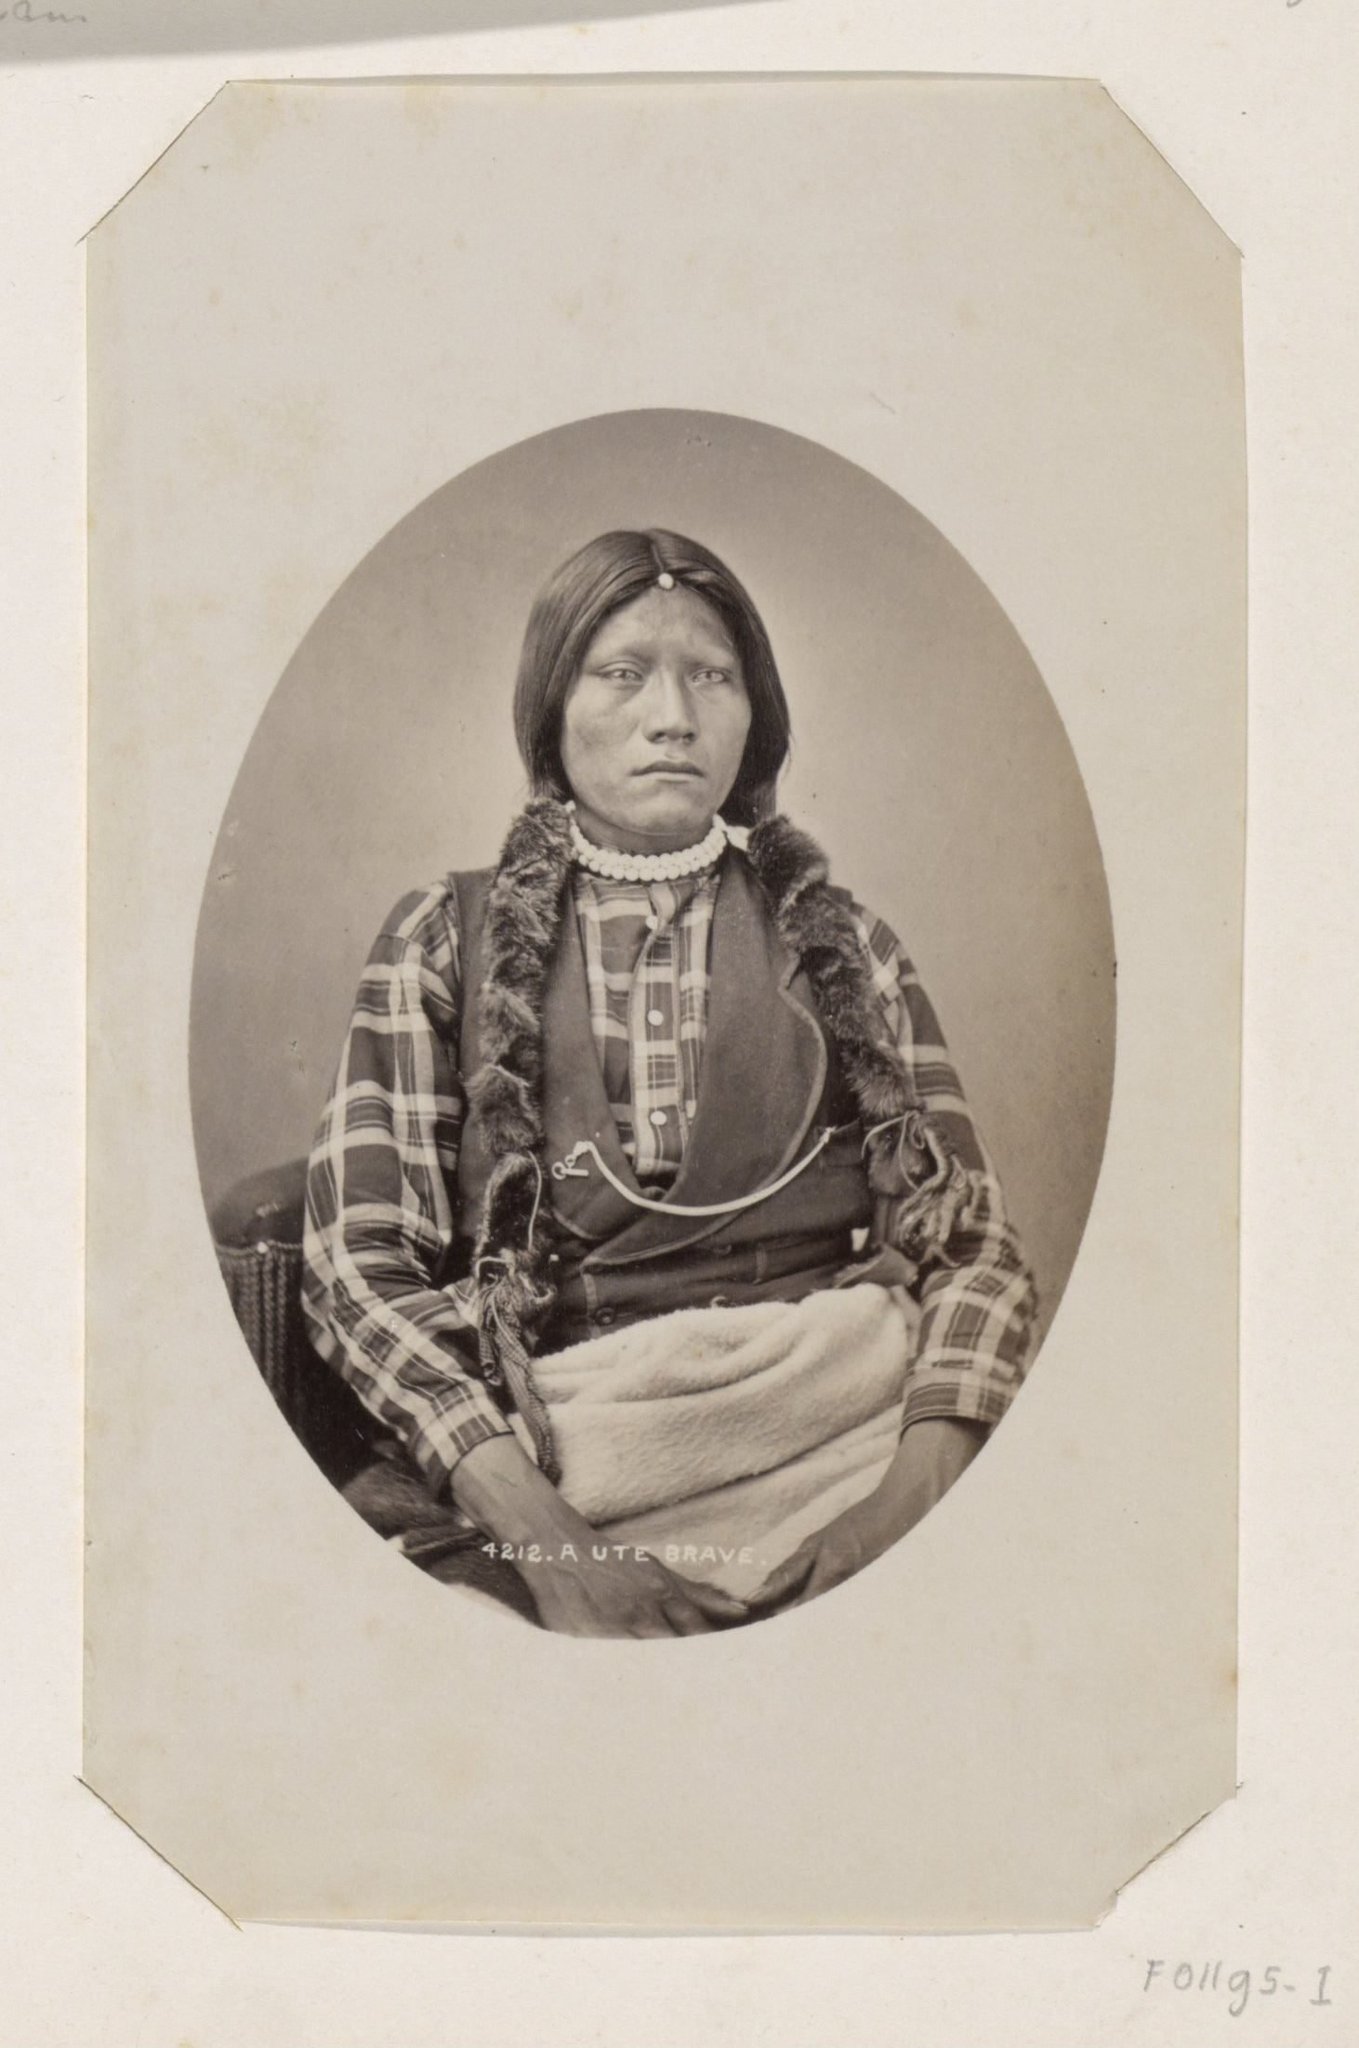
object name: photograph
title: Portret van een Ute-man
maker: Anonymous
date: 1860-1900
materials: cardboard, paper, photographic support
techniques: albumen print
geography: united states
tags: indigenous peoples of north america, united states of america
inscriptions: negative number: ‘4212’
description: Portret van een Ute-man. Onderdeel van Fotoalbum van een reis door de Verenigde Staten, Honolulu, Nederlands-Indië, Aden, Zanzibar en Zuidelijk Afrika.